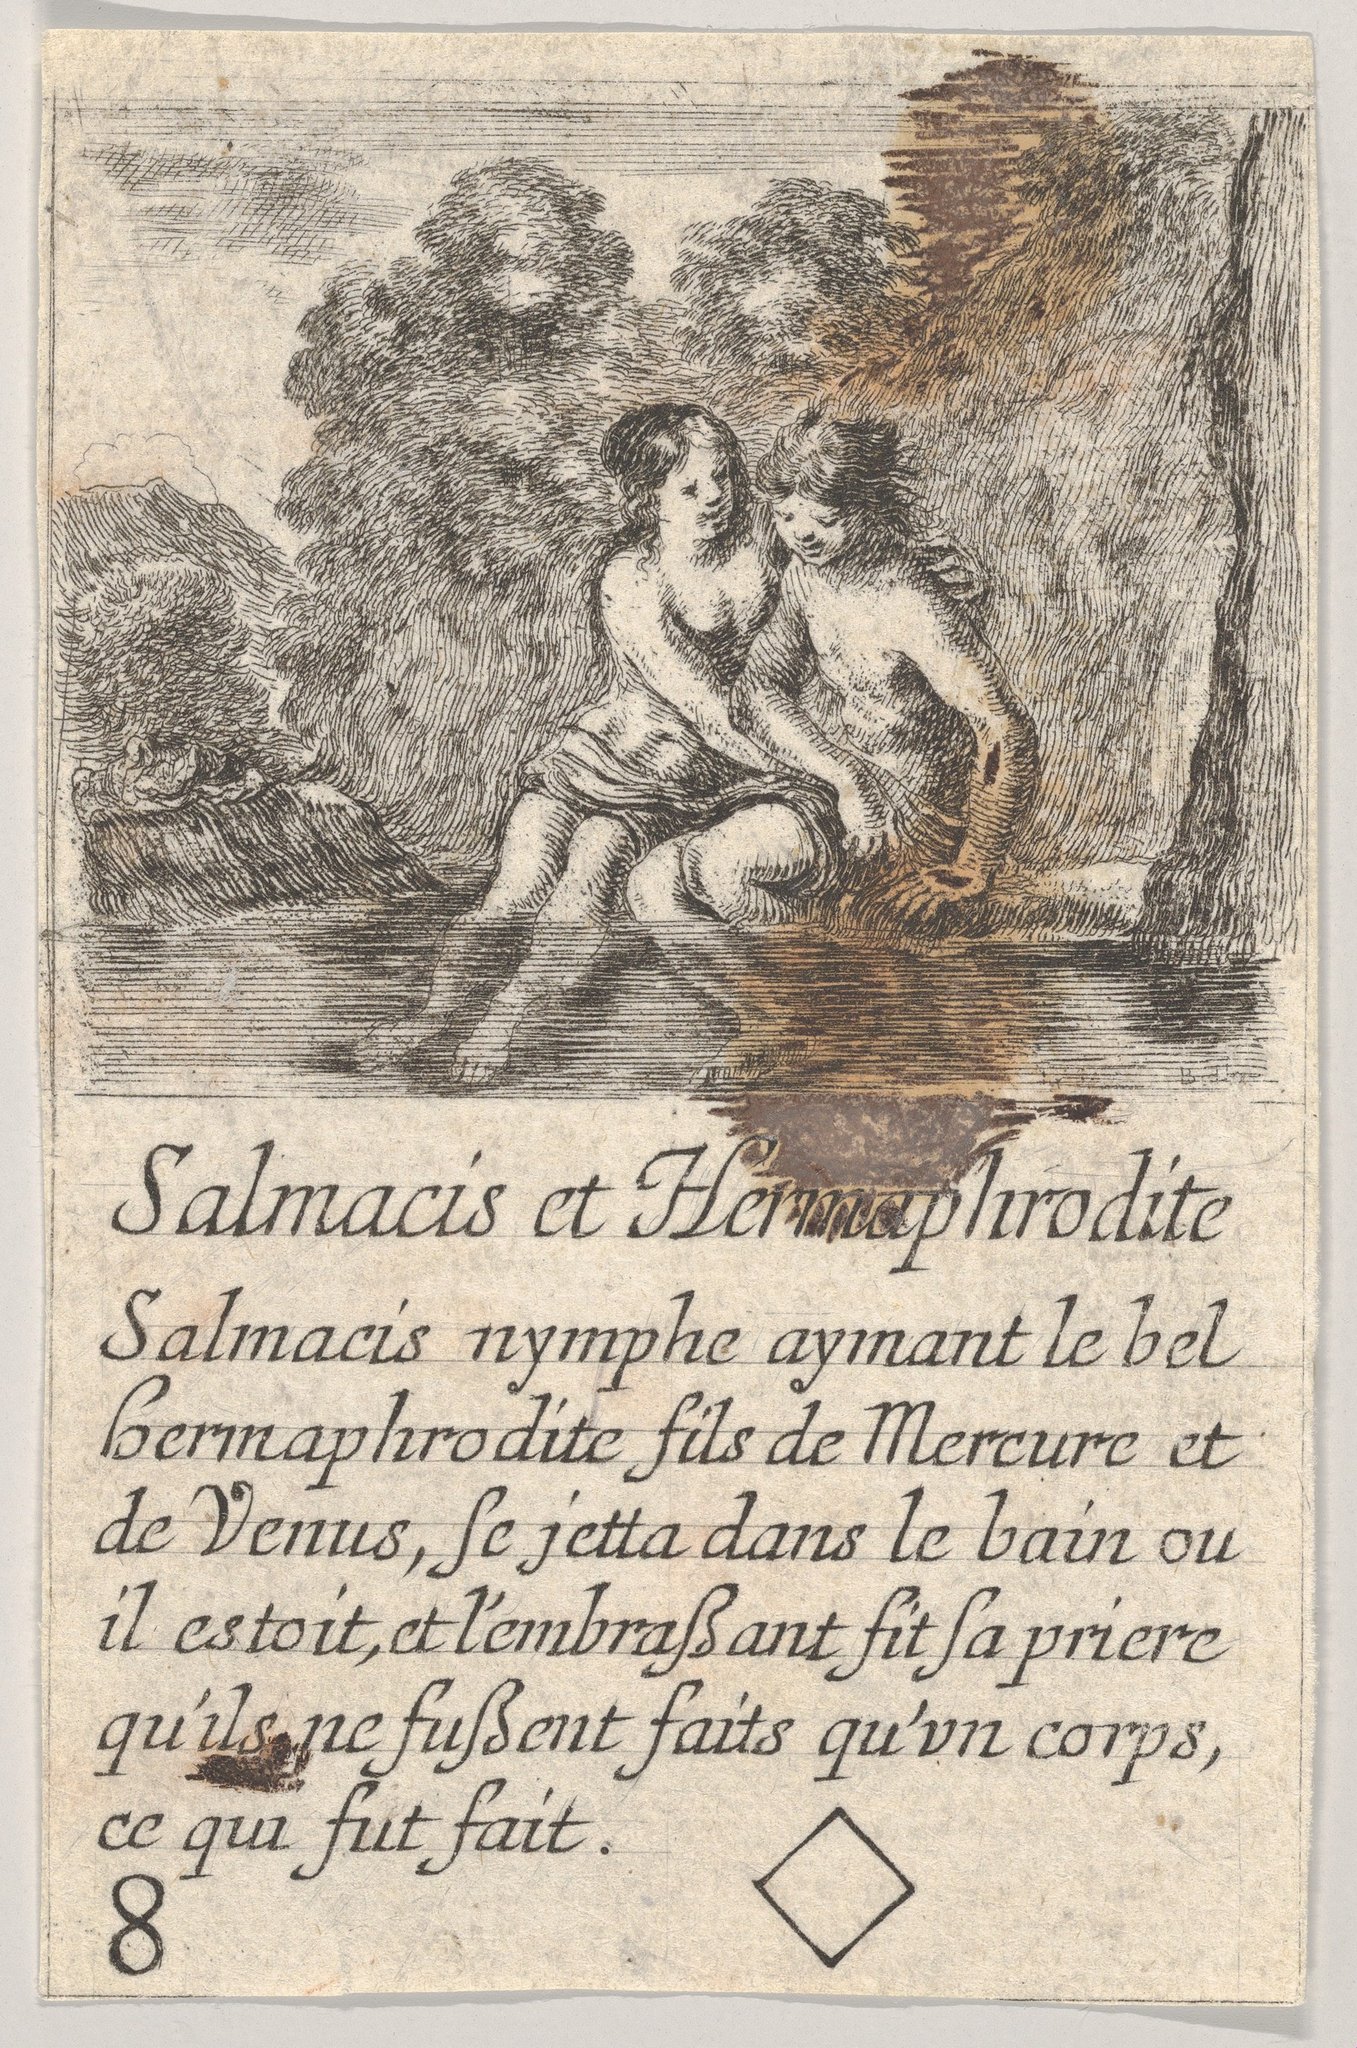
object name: print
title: Salmacis and Hermaphrodite, from "Game of Mythology" (Jeu de la Mythologie)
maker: stefano della bella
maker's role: artist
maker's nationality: italian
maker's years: 1610-1664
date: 1644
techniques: etching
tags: hermaphrodites,nymphs